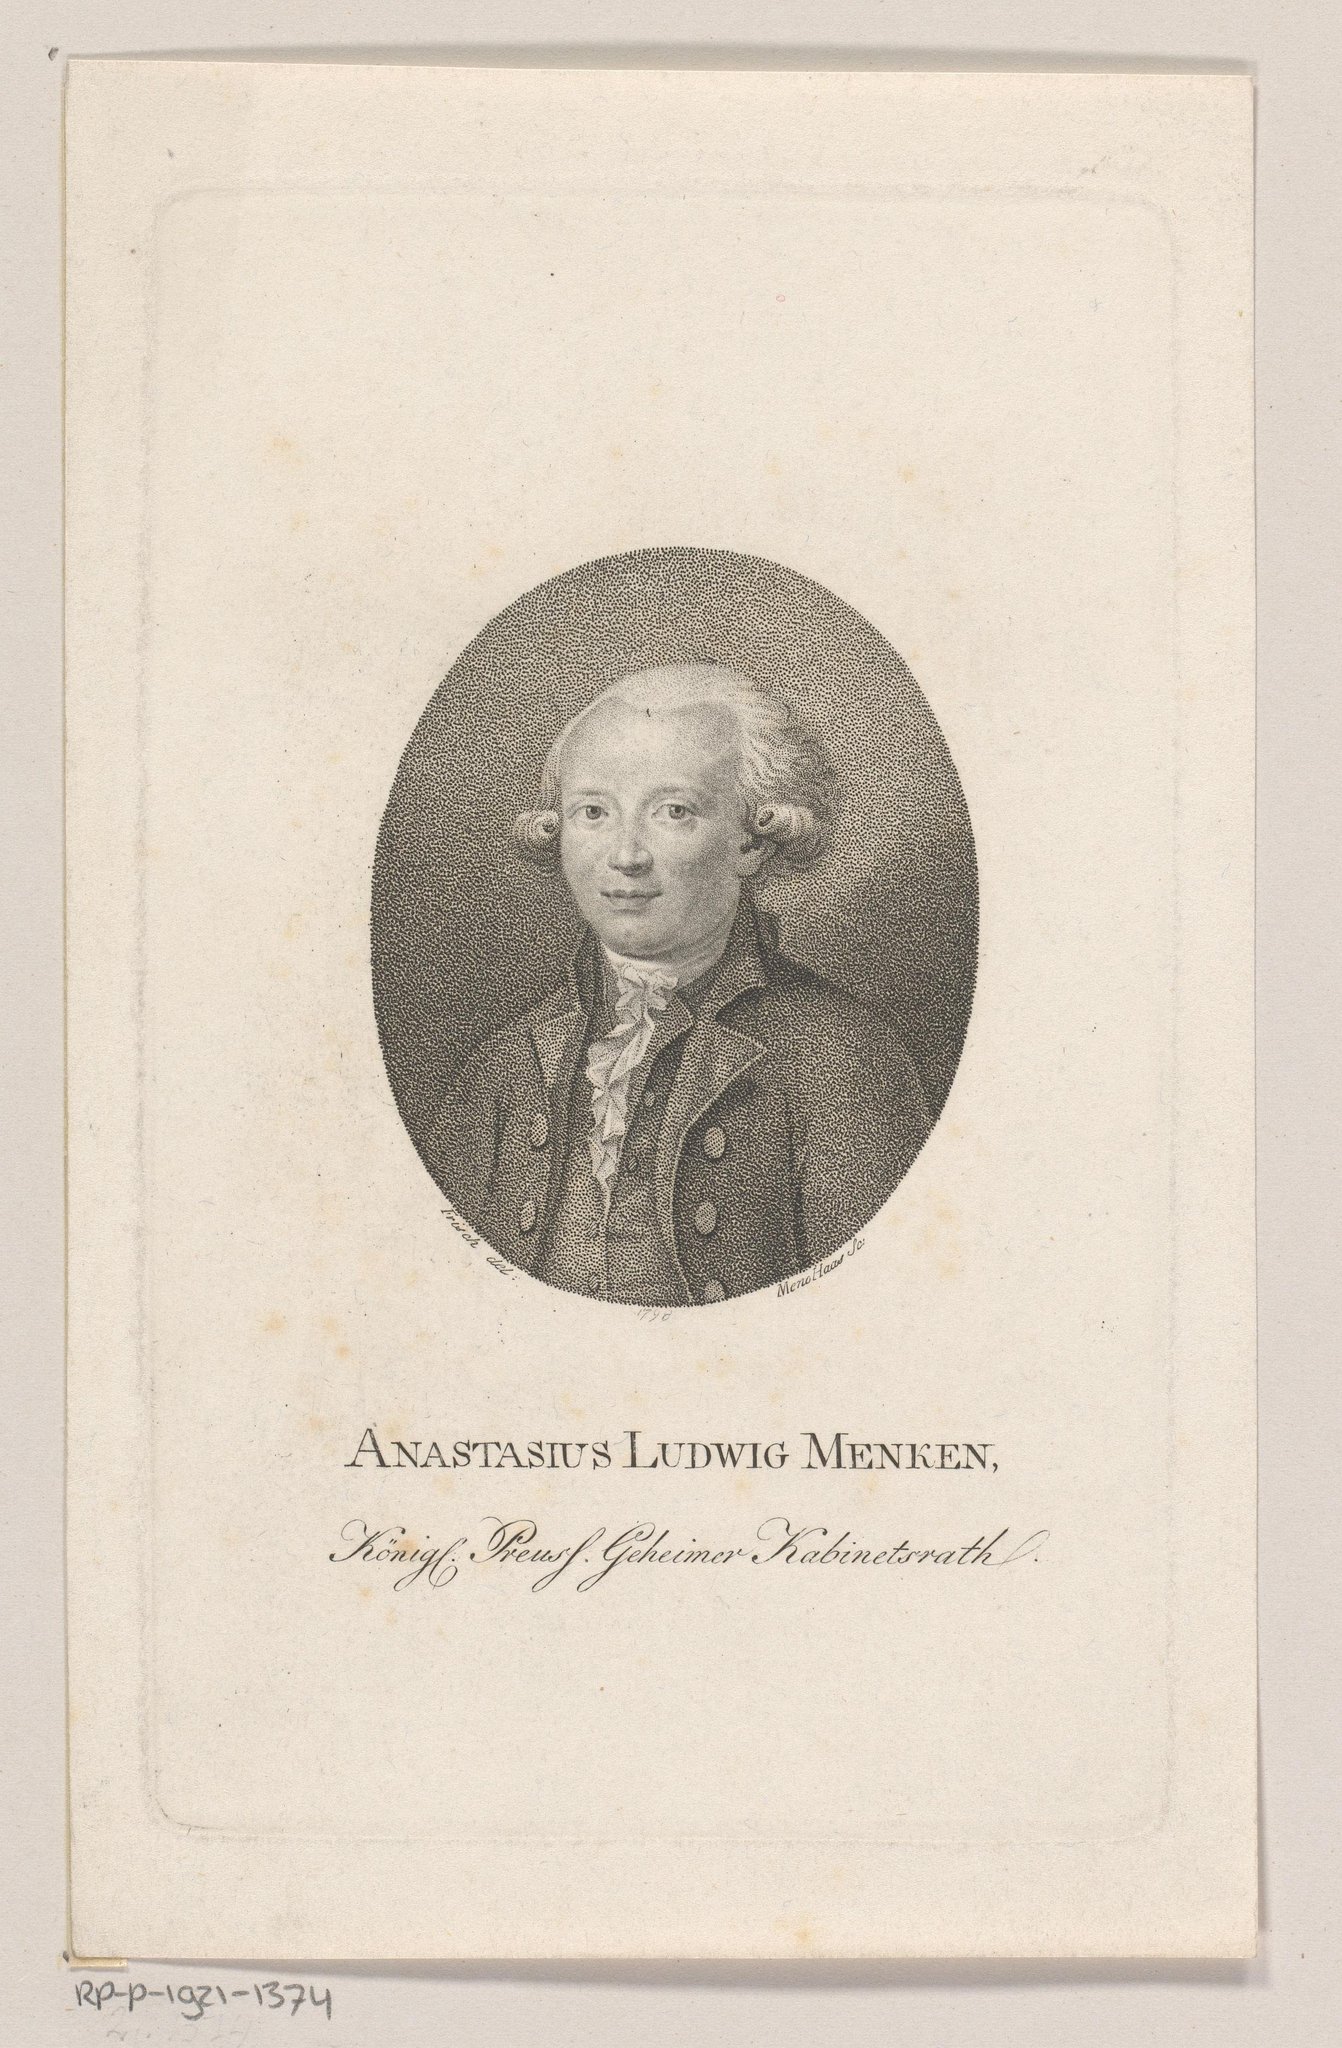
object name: print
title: Anastasius Ludwig Mencke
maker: meno haas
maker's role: print maker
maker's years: 1752-1833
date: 1798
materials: paper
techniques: etching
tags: historical persons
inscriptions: collector's mark: Lugt 2233